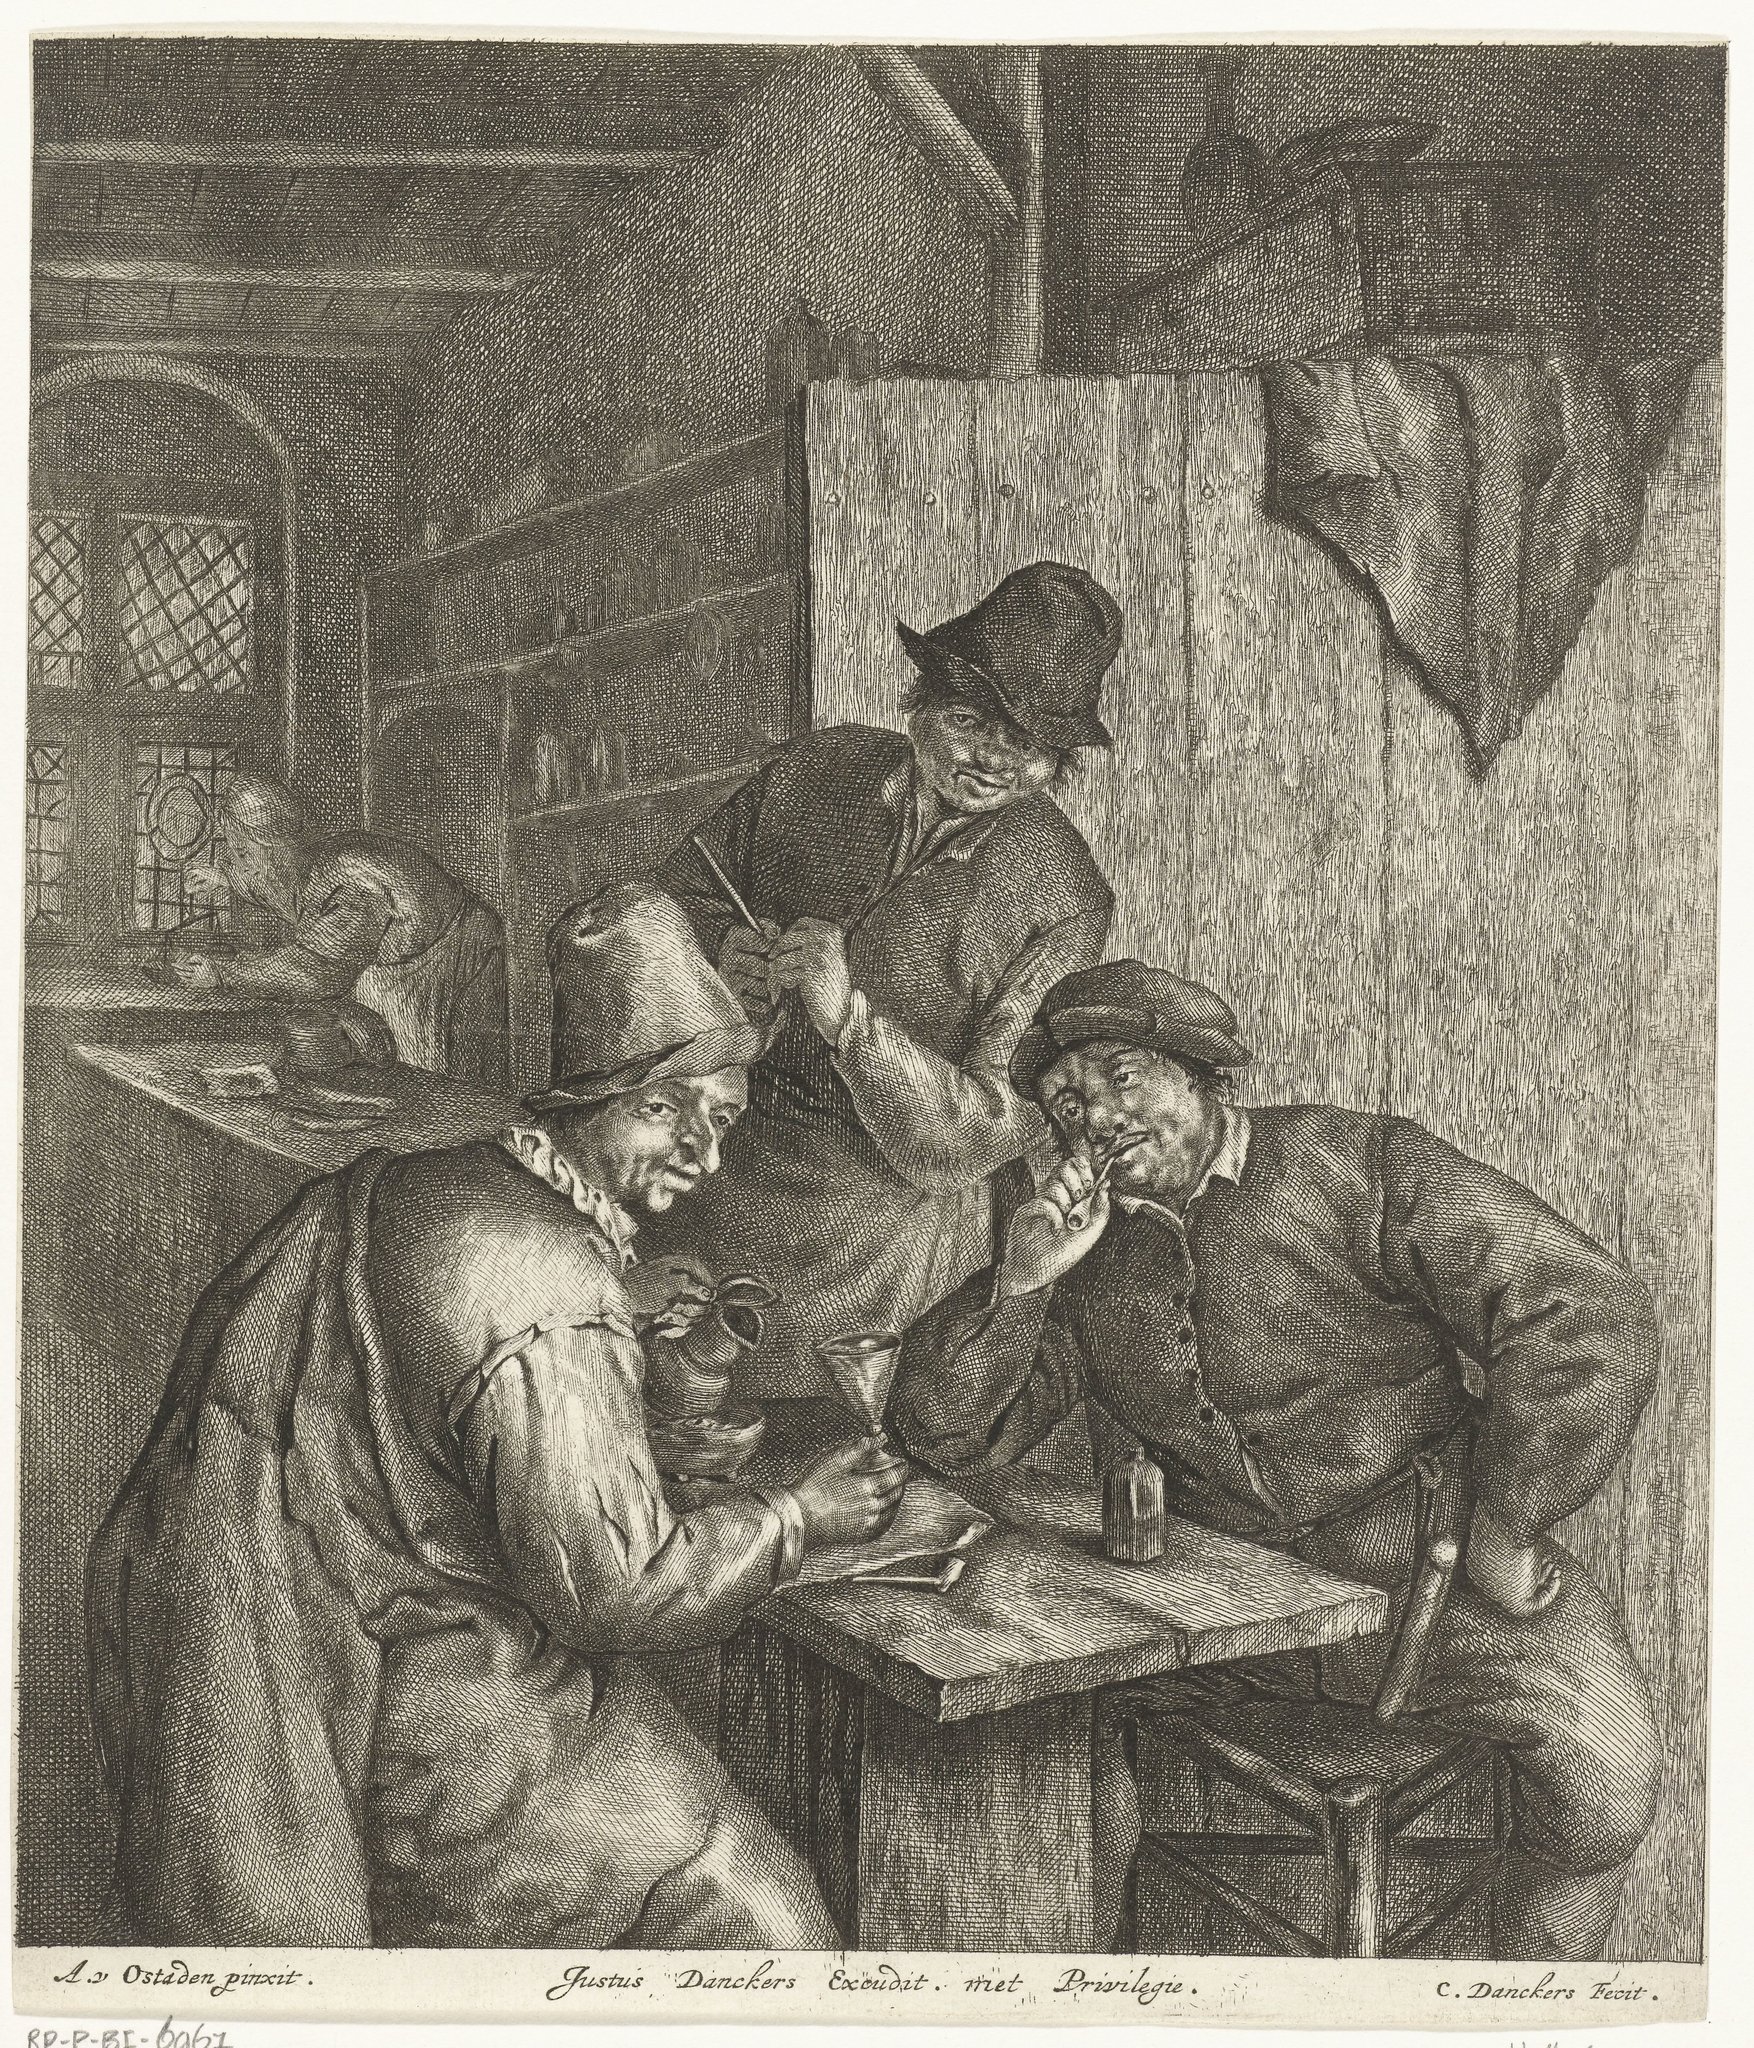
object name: print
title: Drie drinkende en rokende boeren in herberg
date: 1613-1656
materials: paper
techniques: etching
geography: netherlands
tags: inn, coffee-house, public house, etc., drinks, stimulants, drugs (+ taking (particular) foodstuffs: eating, drinking, smoking, chewing, etc.), drinking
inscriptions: collector's mark: Lugt 240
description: Prent naar schilderij van Adriaen van Ostade.